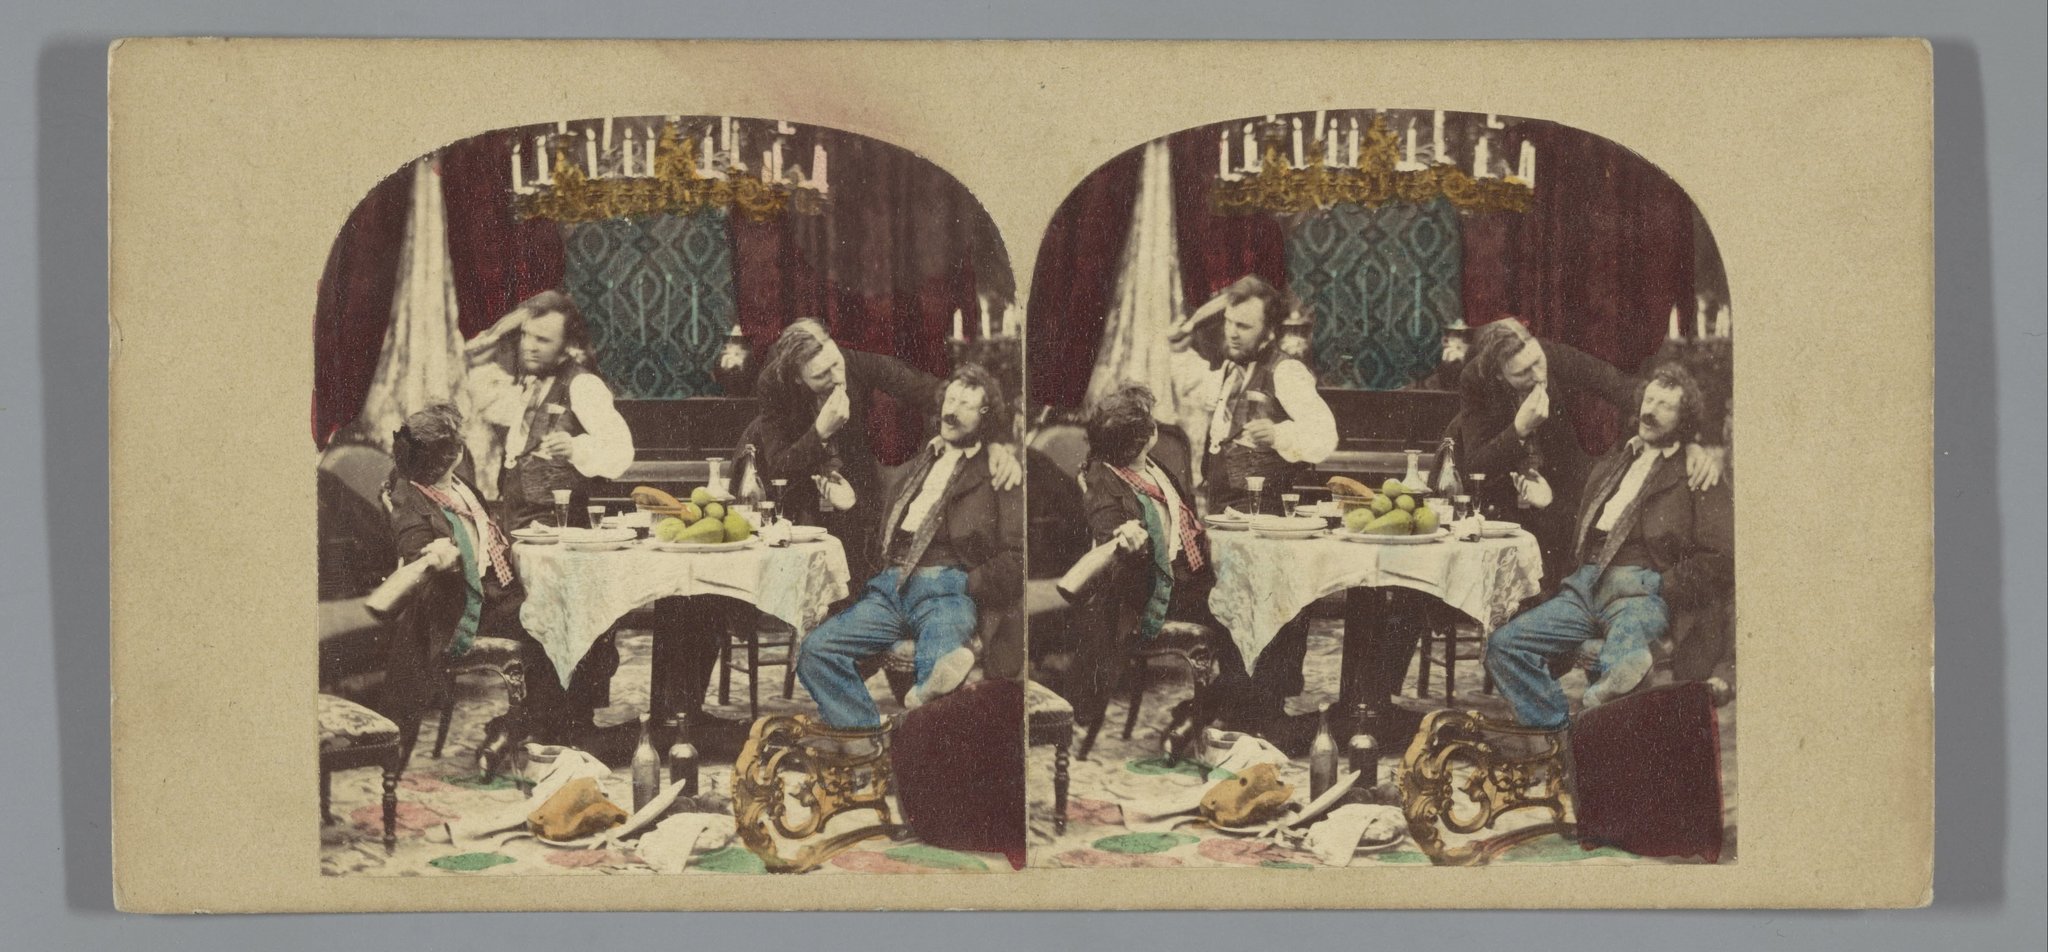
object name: stereograph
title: Vechtende mannen rond een tafel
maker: Anonymous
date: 1852-1863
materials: cardboard, paper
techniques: albumen print, hand coloring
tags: fighting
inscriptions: number: ‘17’, retailer's mark: ‘Nolet & Zoon/ Utrecht’